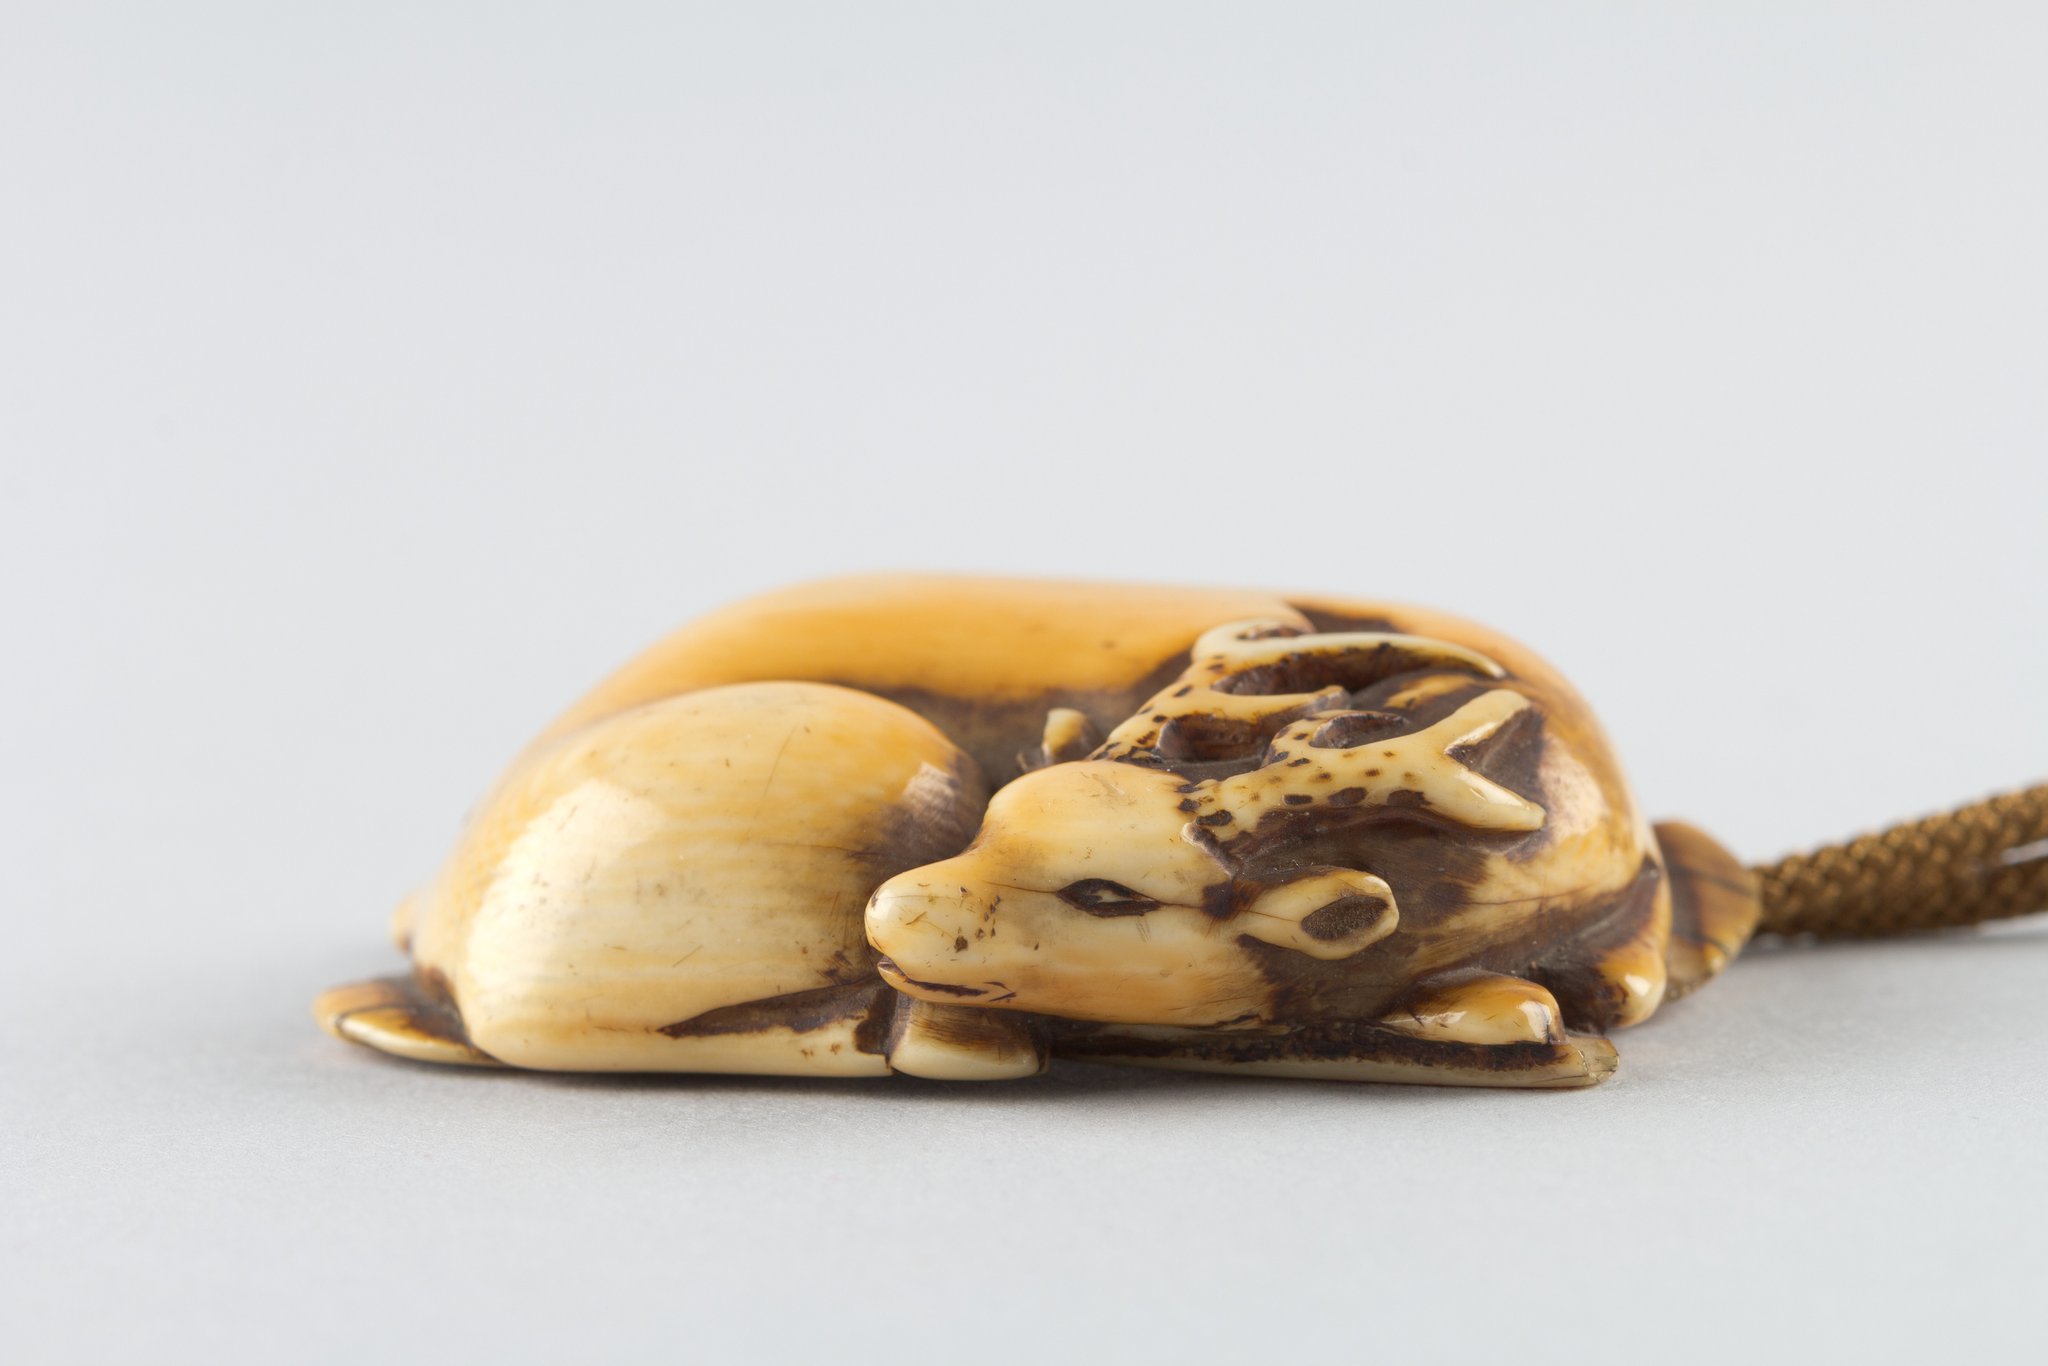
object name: netsuke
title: Netsuke in the Shape of a Deer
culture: japanese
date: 1801-1900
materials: ivory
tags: deer